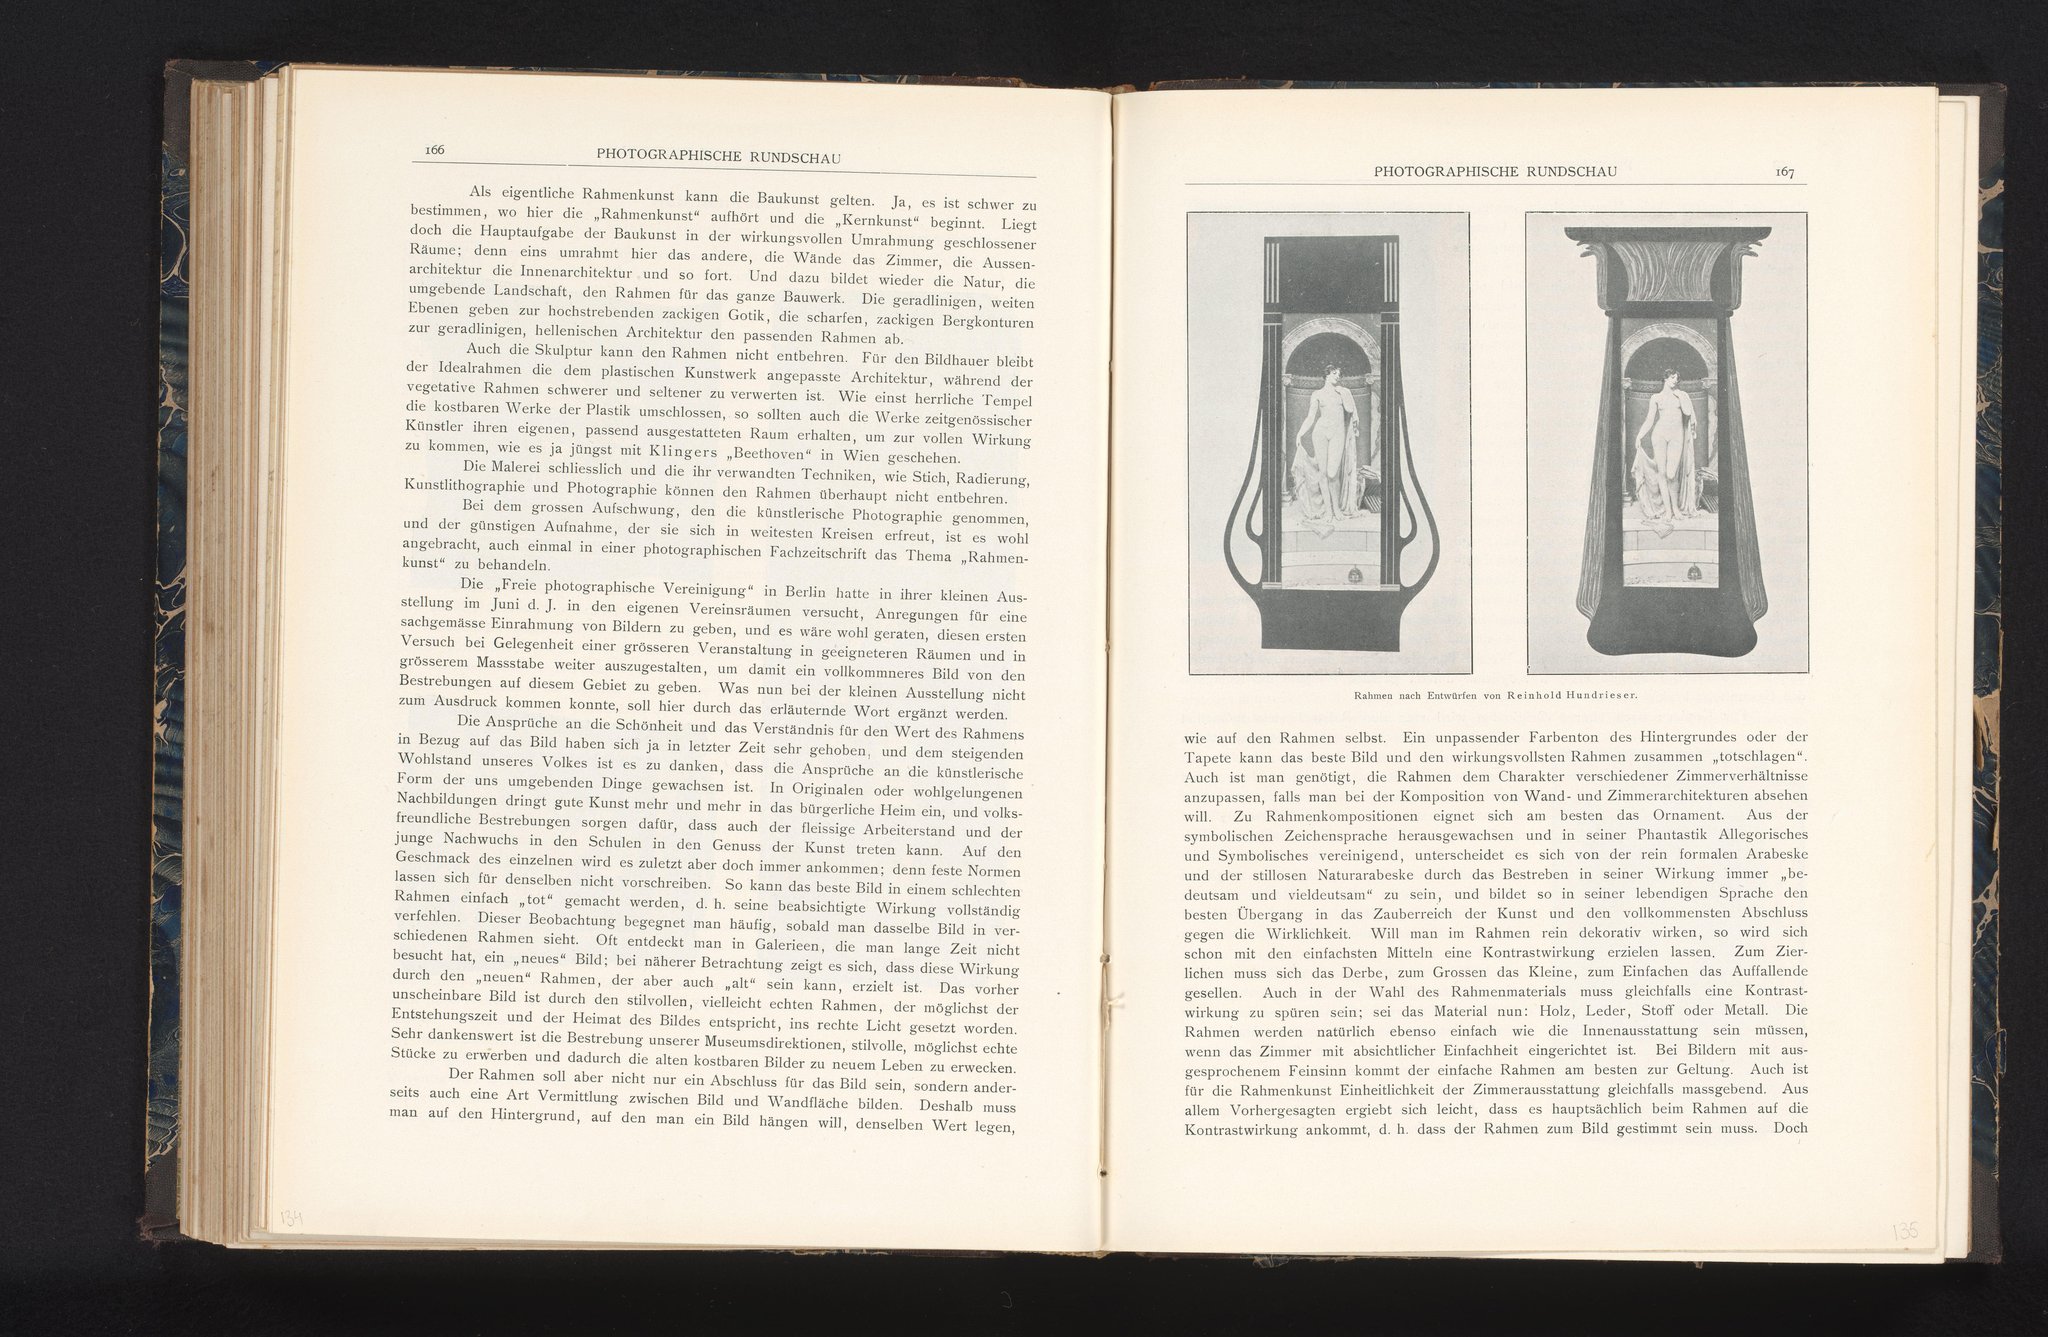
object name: photomechanical print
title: Gezicht op twee lijsten met daarin een afbeelding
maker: Anonymous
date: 1897-1902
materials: paper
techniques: autotype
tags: frame of painting, etc.